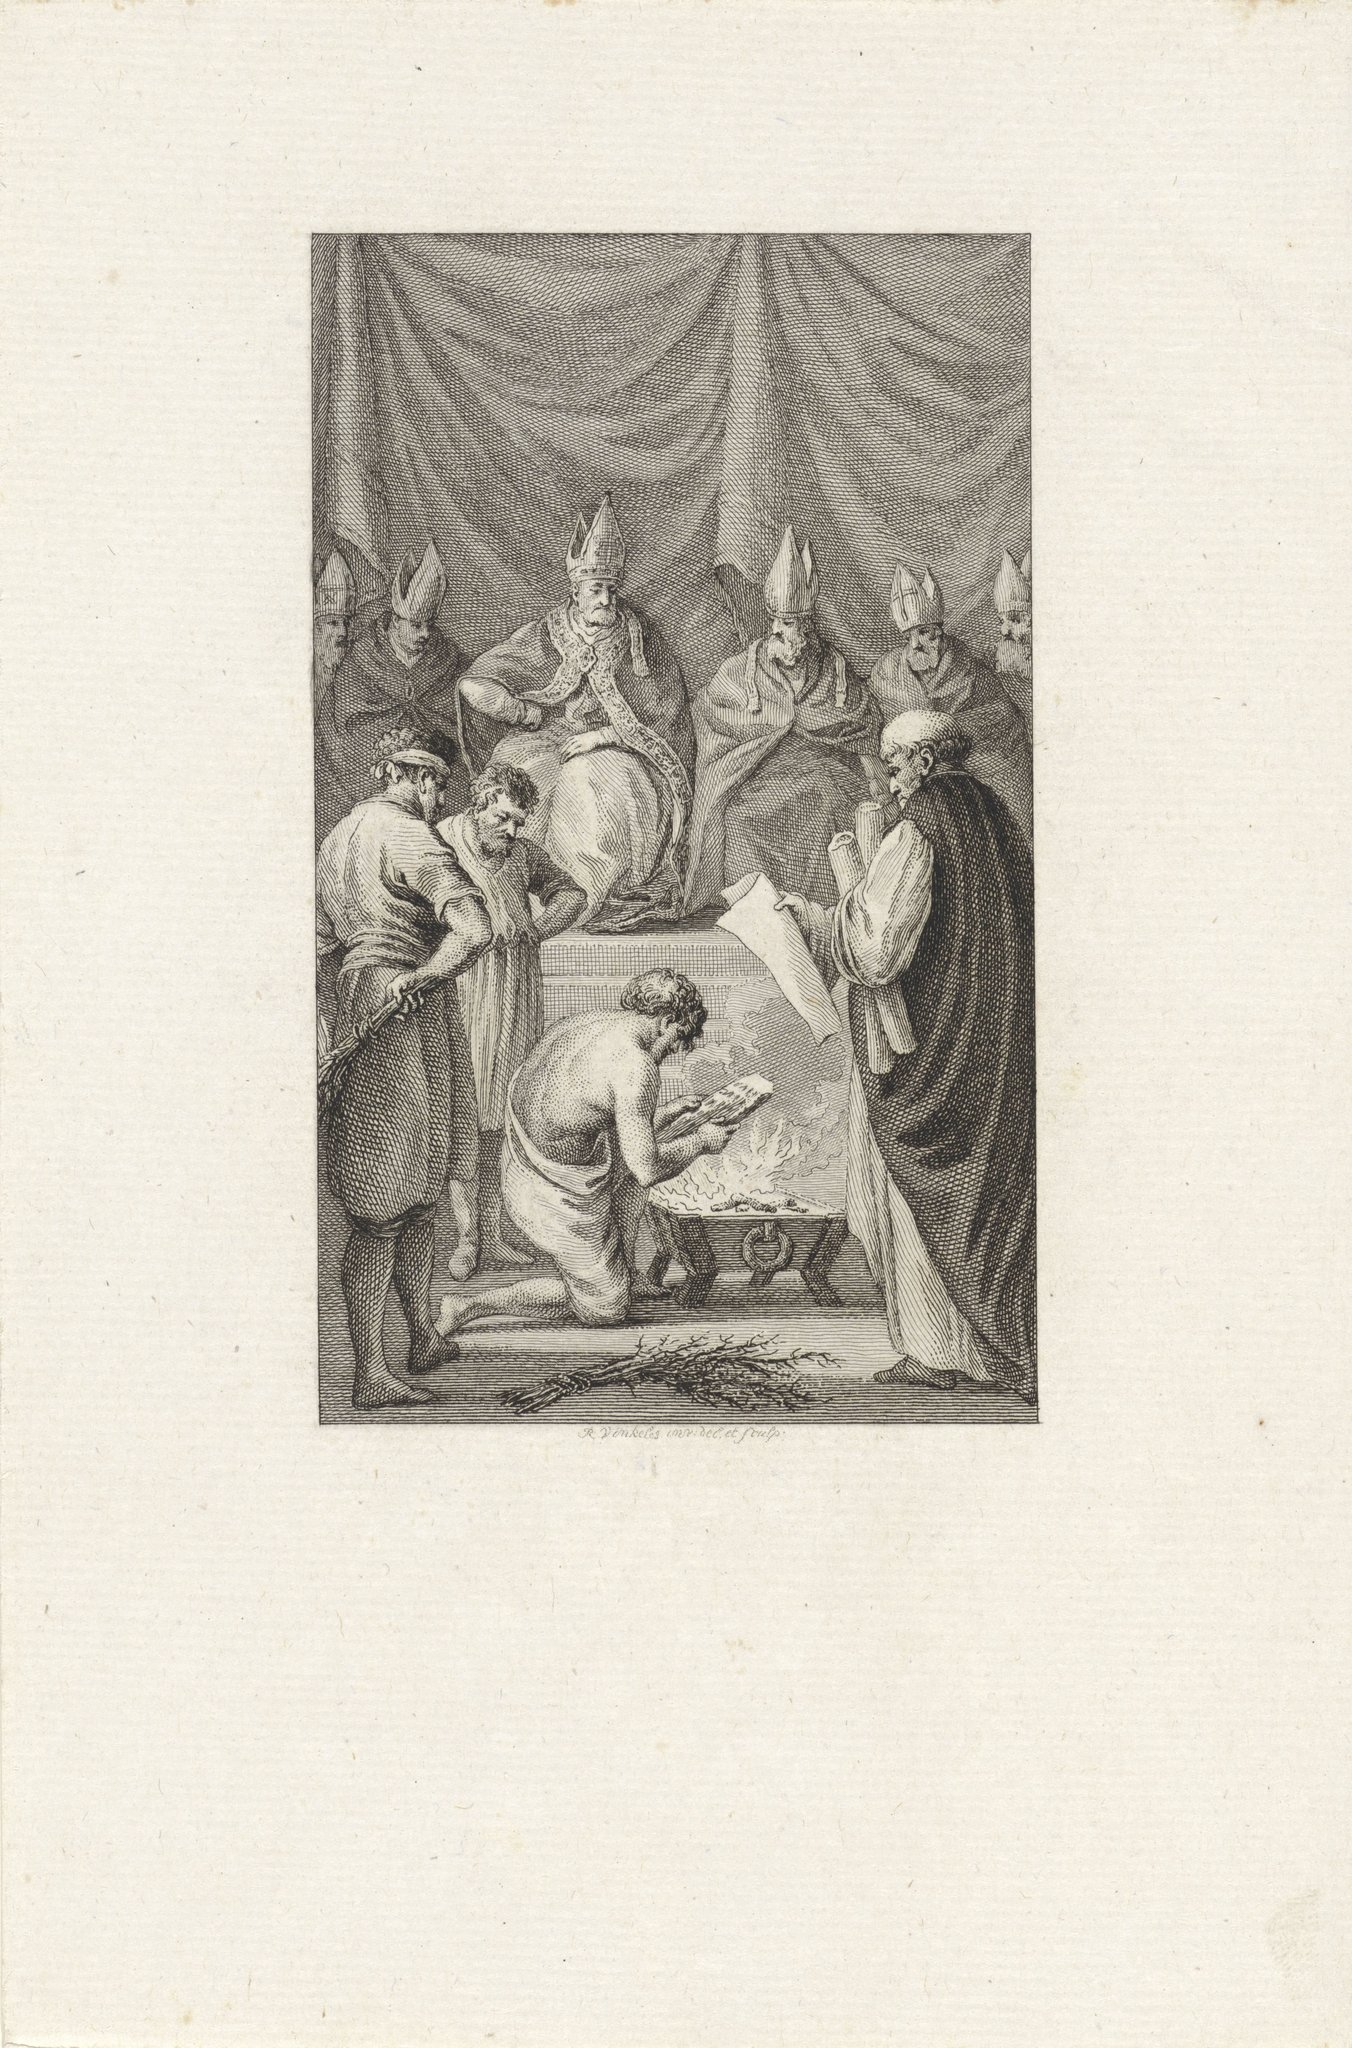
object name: print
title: Godschalk ondergaat zijn straf en verbrandt zijn boeken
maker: reinier vinkeles (i)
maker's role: draughtsman, print maker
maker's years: 1741-1816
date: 1807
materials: paper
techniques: engraving, etching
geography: amsterdam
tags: archbishop, bishop, etc. (roman catholic), torture (+ judge), rod, birch ~ punishment at school, burning of books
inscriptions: collector's mark: Lugt 2228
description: Een deel van de twaalf bisschoppen kijkt toe hoe de door hen opgelegde straf door Godschalk wordt ondergaan. Godschalk verbrandt boeken nadat hij is afgeranseld met de roede.